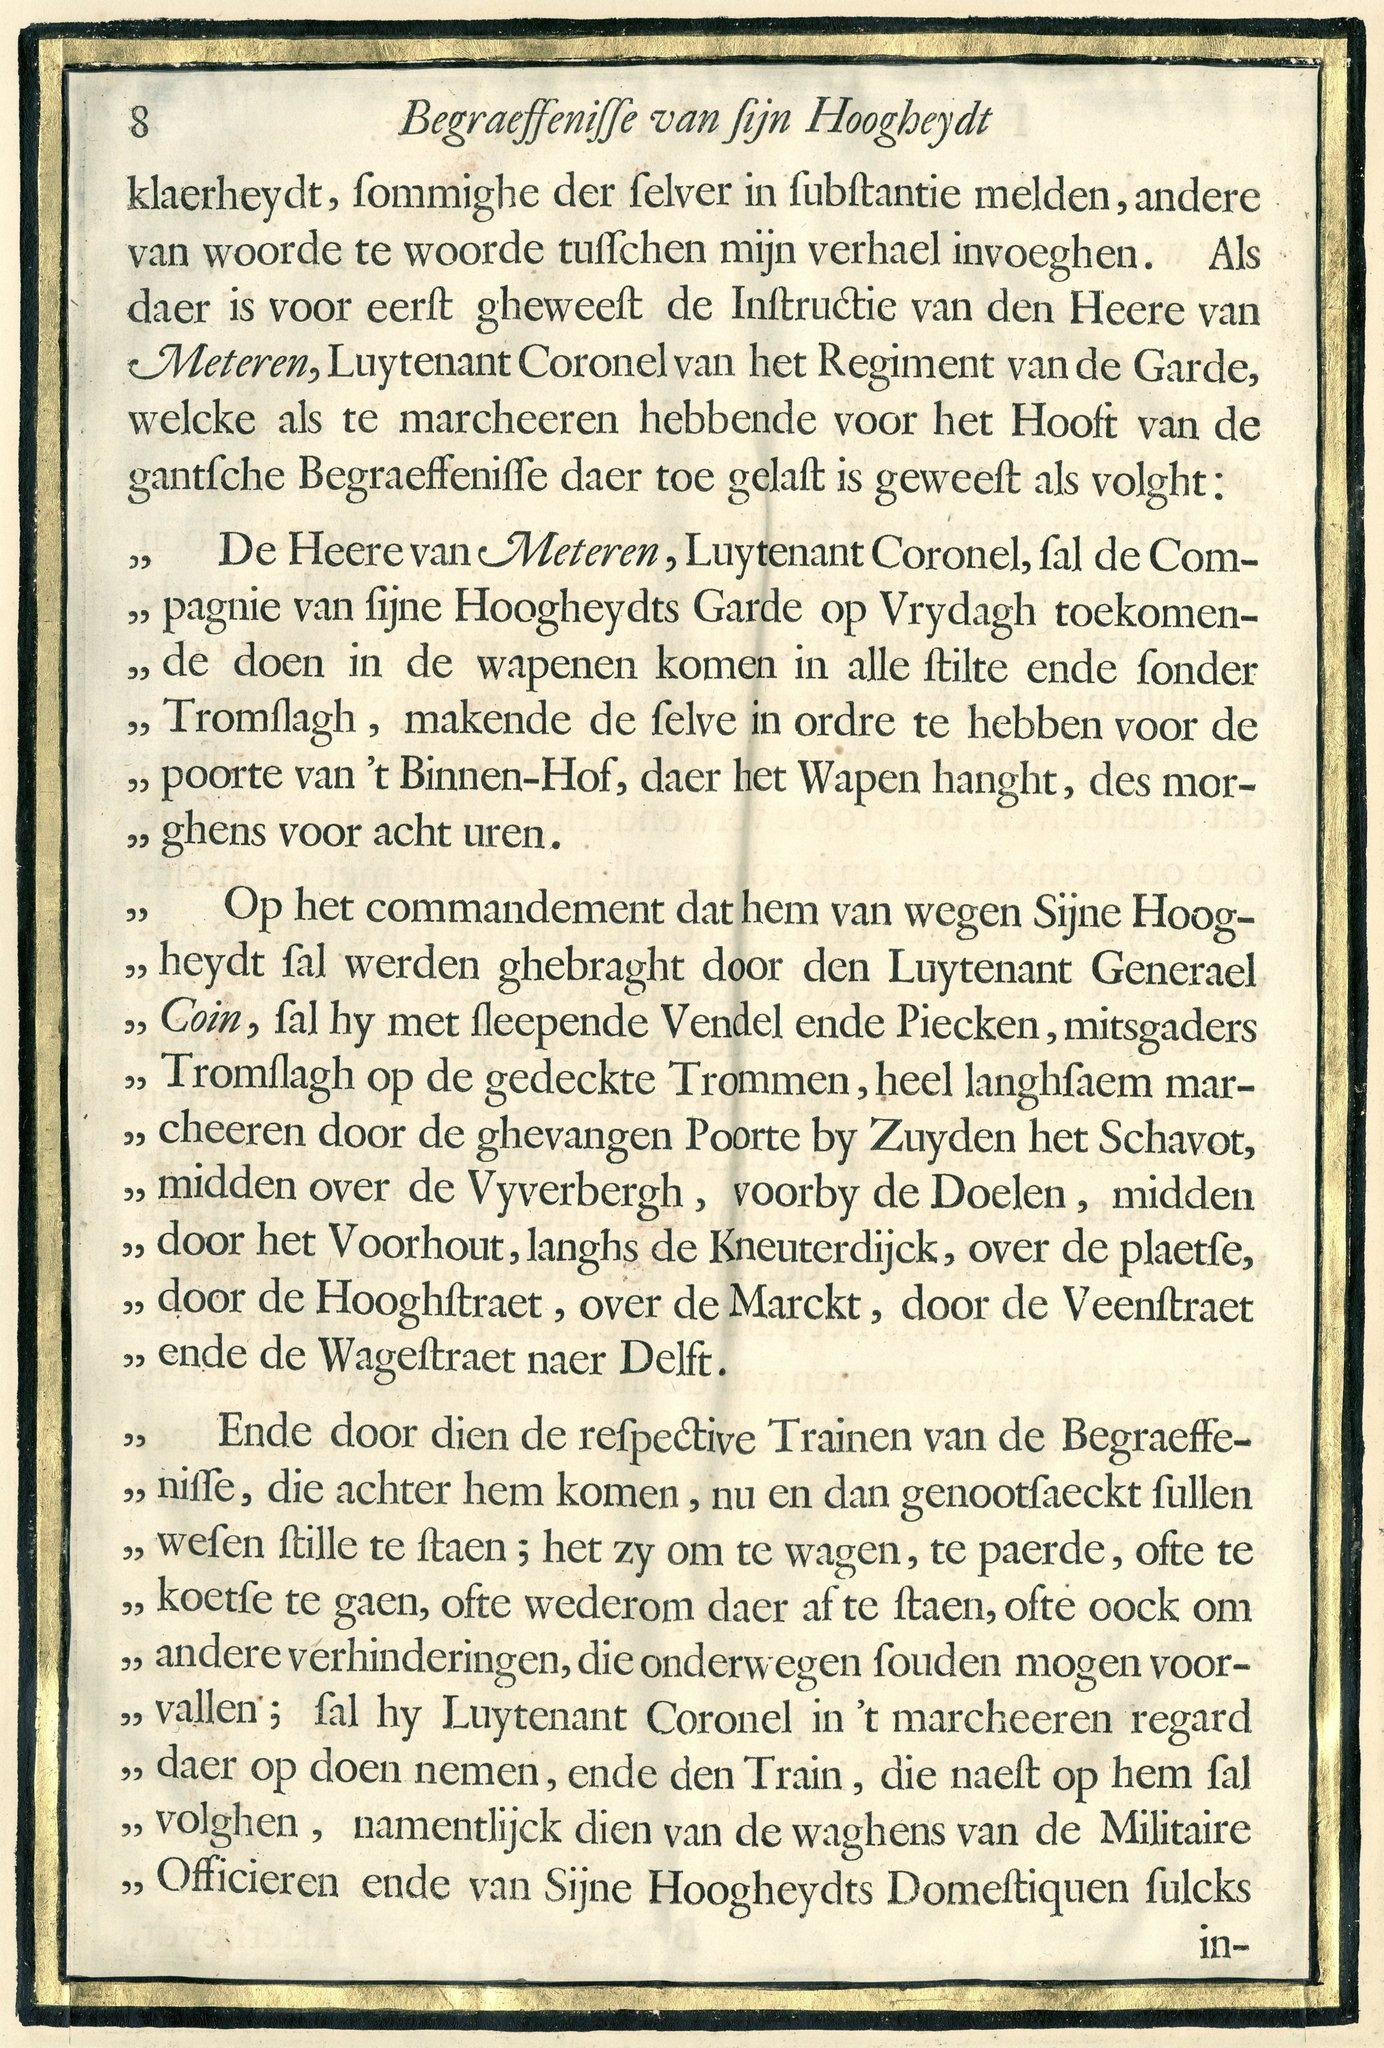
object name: book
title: De beschrijving van de begrafenis van Frederik Hendrik, p. 08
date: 1651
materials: paint, paper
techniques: letterpress printing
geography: amsterdam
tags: delft, frederick henry (prince of orange)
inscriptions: date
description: Pagina 8 van de beschrijving van de begrafenis van Frederik Hendrik. Blad uitgeknipt, versierd met goud en ingeplakt in de luxe editie uit ca. 1755 van het boek 'Begraeffenisse van syne hoogheyt Frederick Henrick' van Pieter Post, uitgegeven te Amsterdam in 1651.